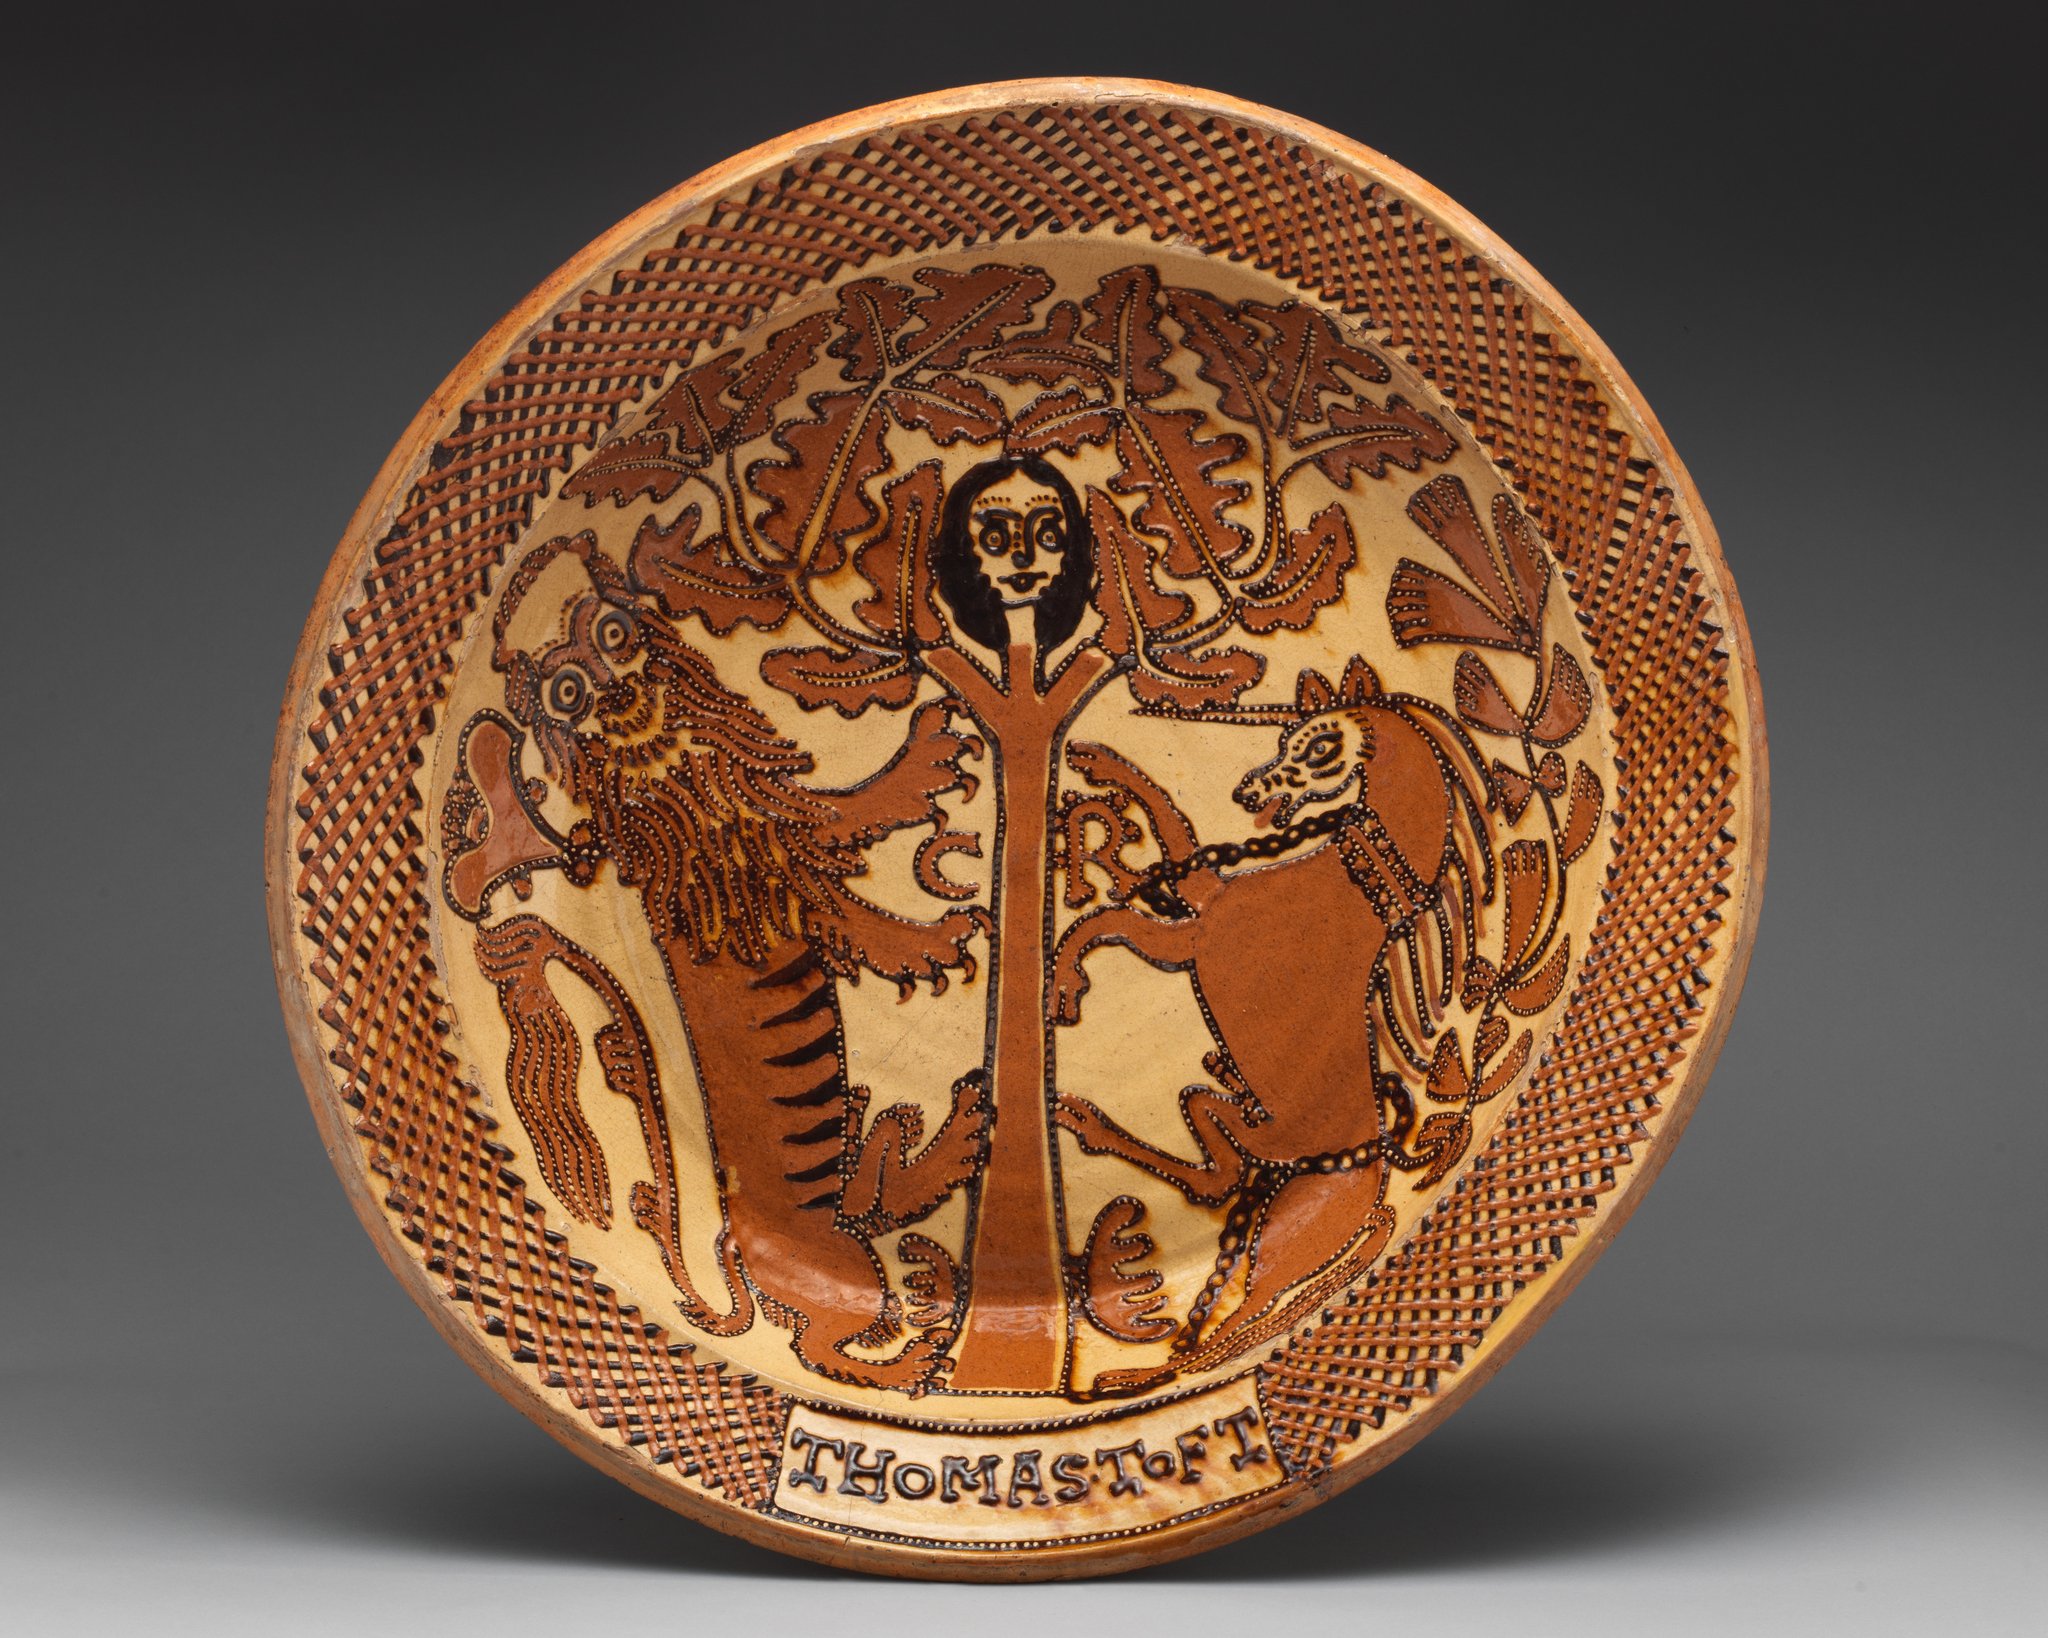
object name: charger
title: Display dish with Charles II (1630–1685) in a tree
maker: thomas toft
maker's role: maker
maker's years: 1589-1689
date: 1680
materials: earthenware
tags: unicorns,lions,trees,charles ii